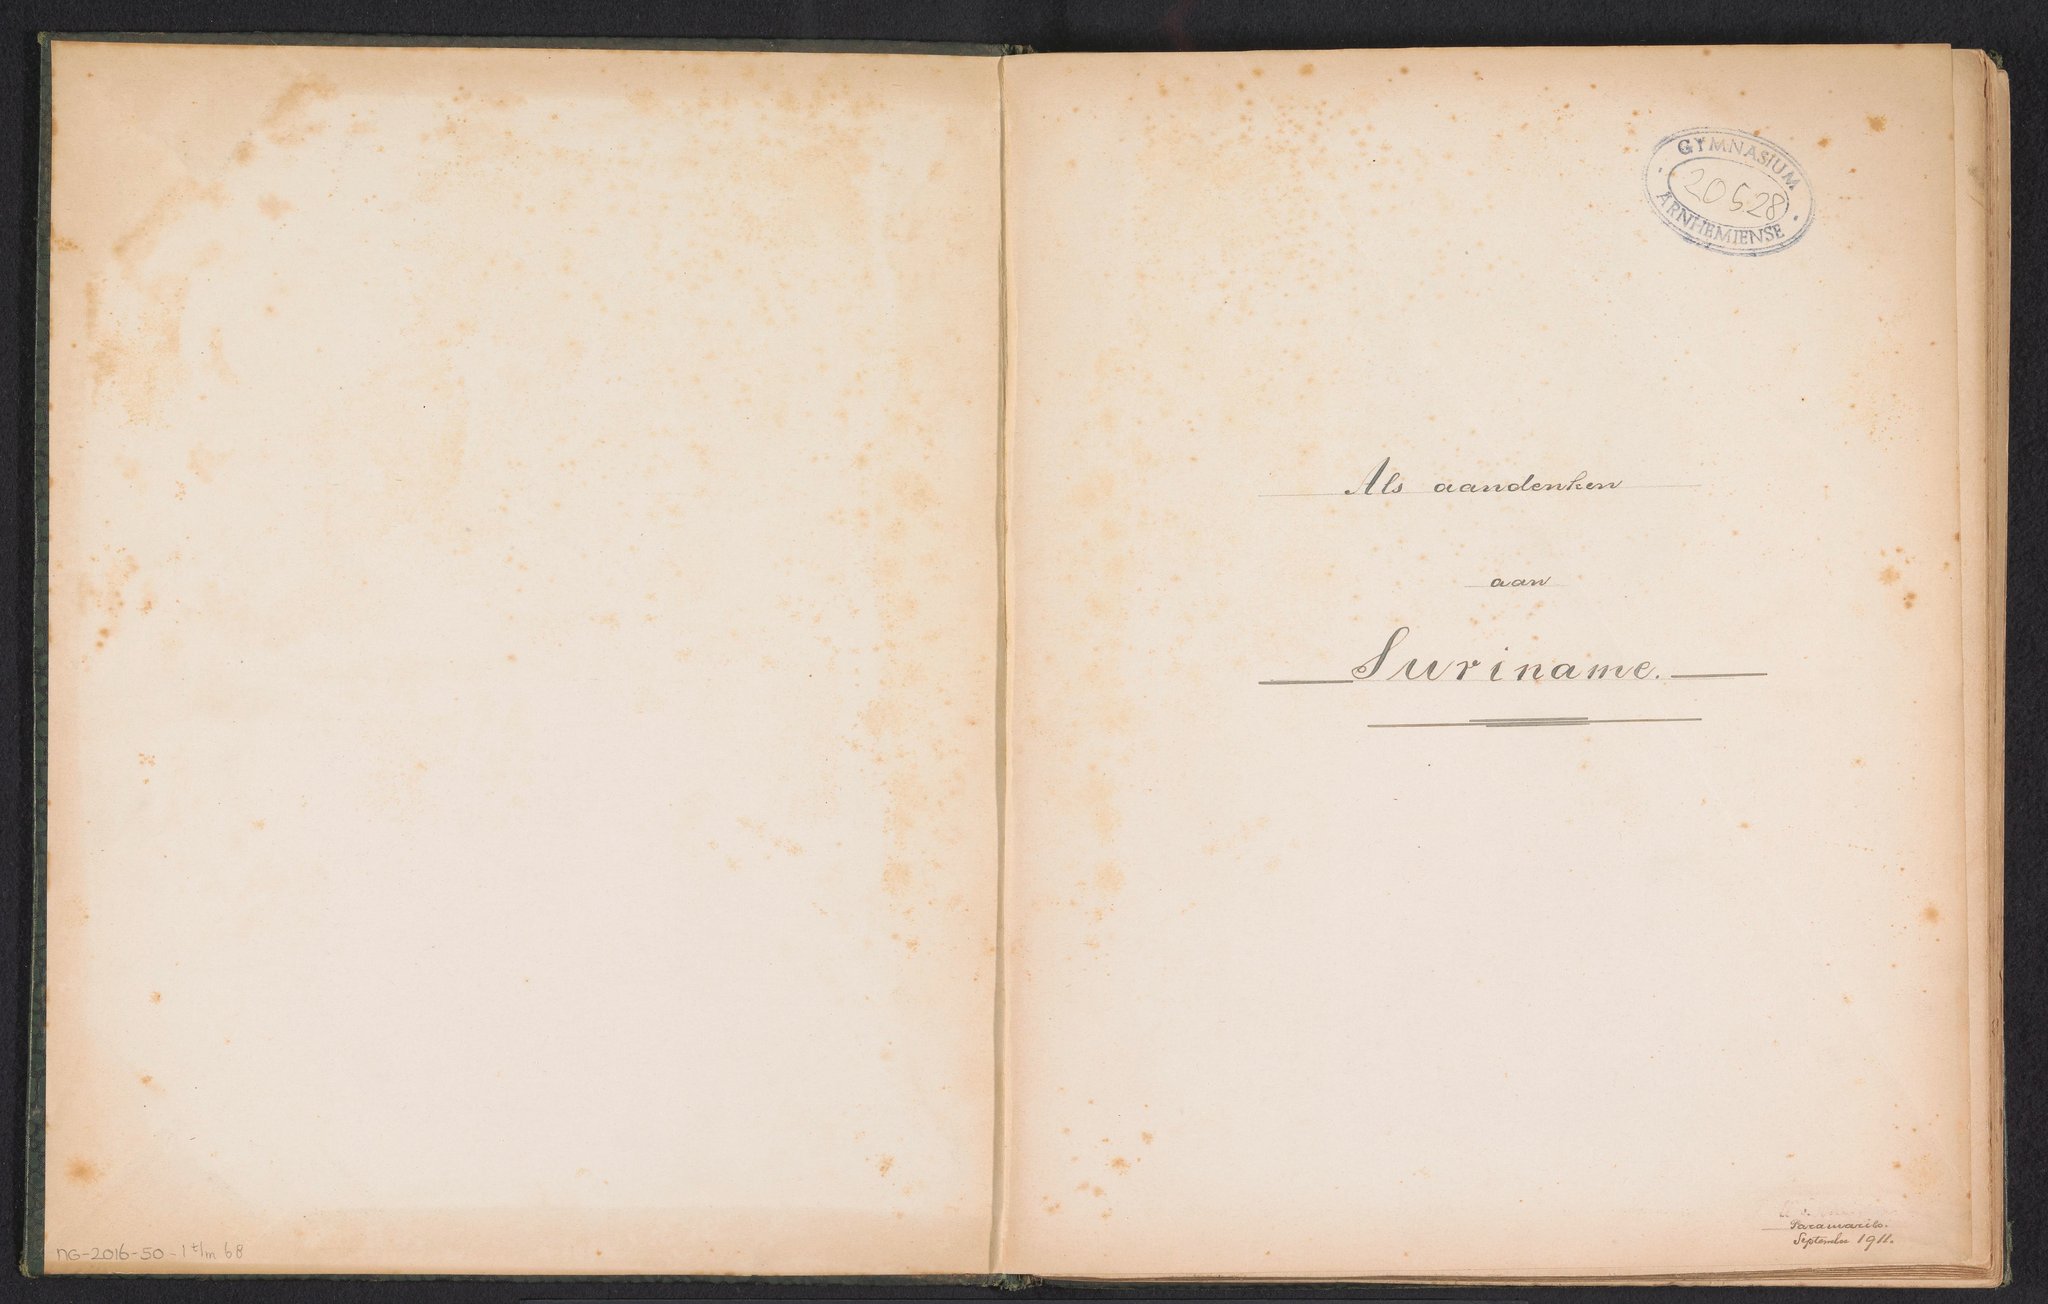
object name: postcard album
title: Album met 68 prentbriefkaarten 'Als aandenken aan Suriname'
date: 1900-1910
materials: paper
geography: paramaribo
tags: suriname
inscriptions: collector's mark: ‘Gymnasium Arnhemiense 20528’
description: Verzameling van 68 briefkaarten uit Suriname bijeengebracht in een album als aandenken aan een verblijf in Suriname in september 1911. De kaarten hebben als onderwerp straatgezichten in Paramaribo, het binnenland en verschillende bevolkingsgroepen. Enkele voorbeelden van opschriften: Markt aan de heiligen weg zg Wowojo, Annonce Versch Vleesch, Op de reede van Paramaribo, Javaansche immigranten met muziekinstrumenten, landingsplaats Cabenda Boven Saramacca, Mulattine, Indiaansche vrouw, Sakoonath, Britsch Indische, Javanen, Creole, Boschneger, Daktra (dokter) in Boven-Cottica en Tjin-A-Mooy met zyn Creole echtgenoote.